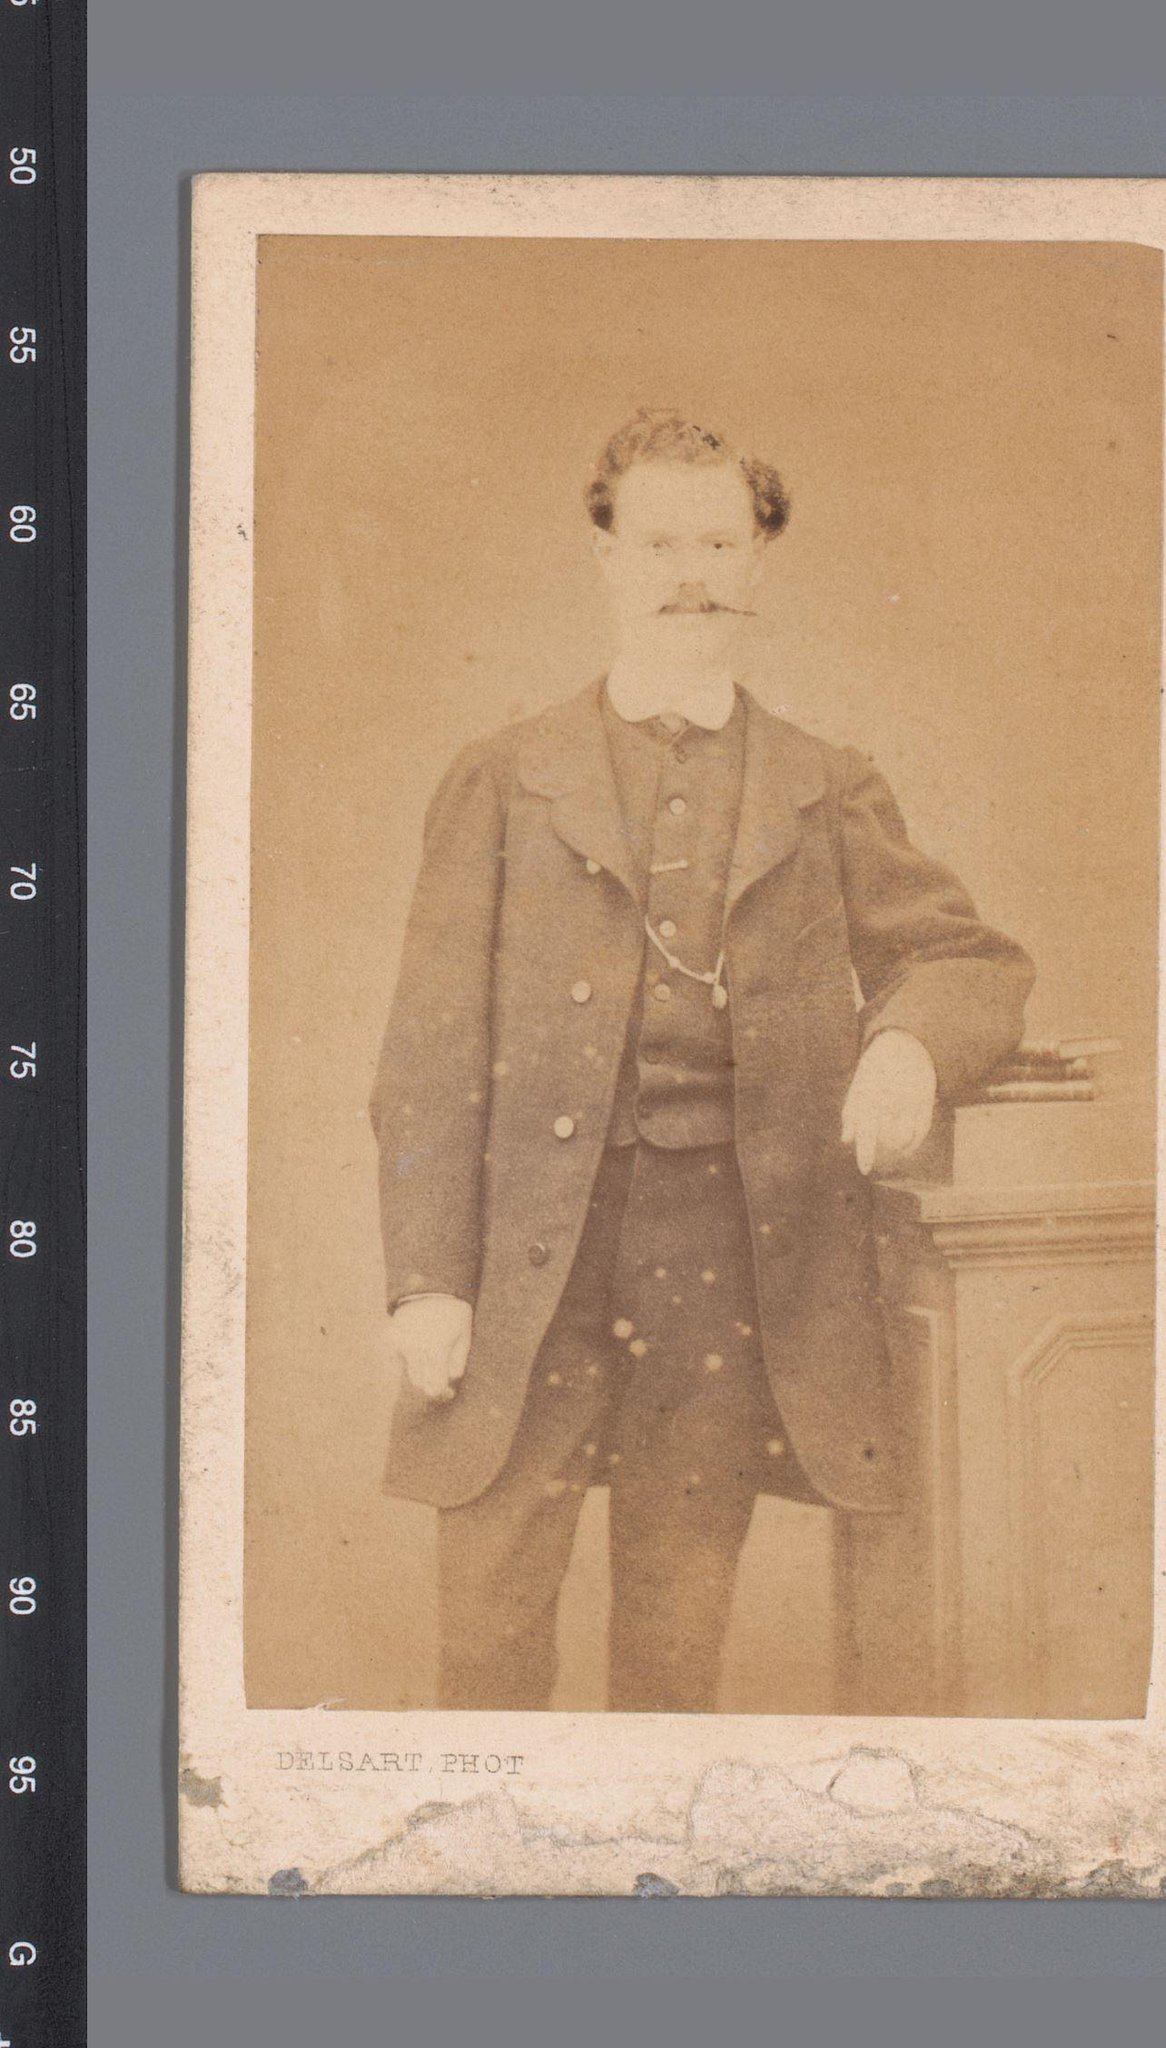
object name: carte de visite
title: Portret van een man, mogelijk Alfred Lardenoir of zijn broer, Adolphe Lardenoir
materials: cardboard, paper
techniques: albumen print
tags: adult man, anonymous historical person portrayed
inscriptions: inscription: ‘à mon cher frère:/ Adolphe Lardenoir/ 18 Julliet 1866/ Alfred Lardenoir’